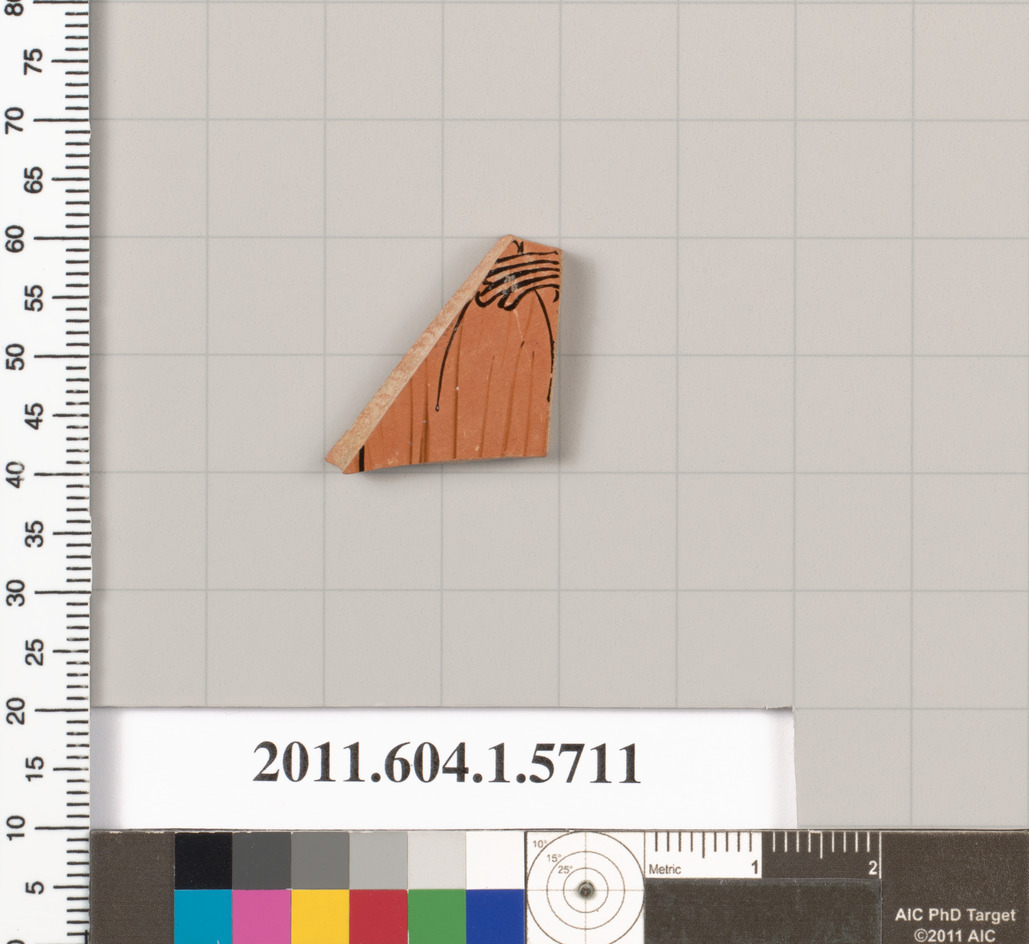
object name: kylix fragment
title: Terracotta fragment of a kylix (drinking cup)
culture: greek, attic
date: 490-480 BCE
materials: terracotta